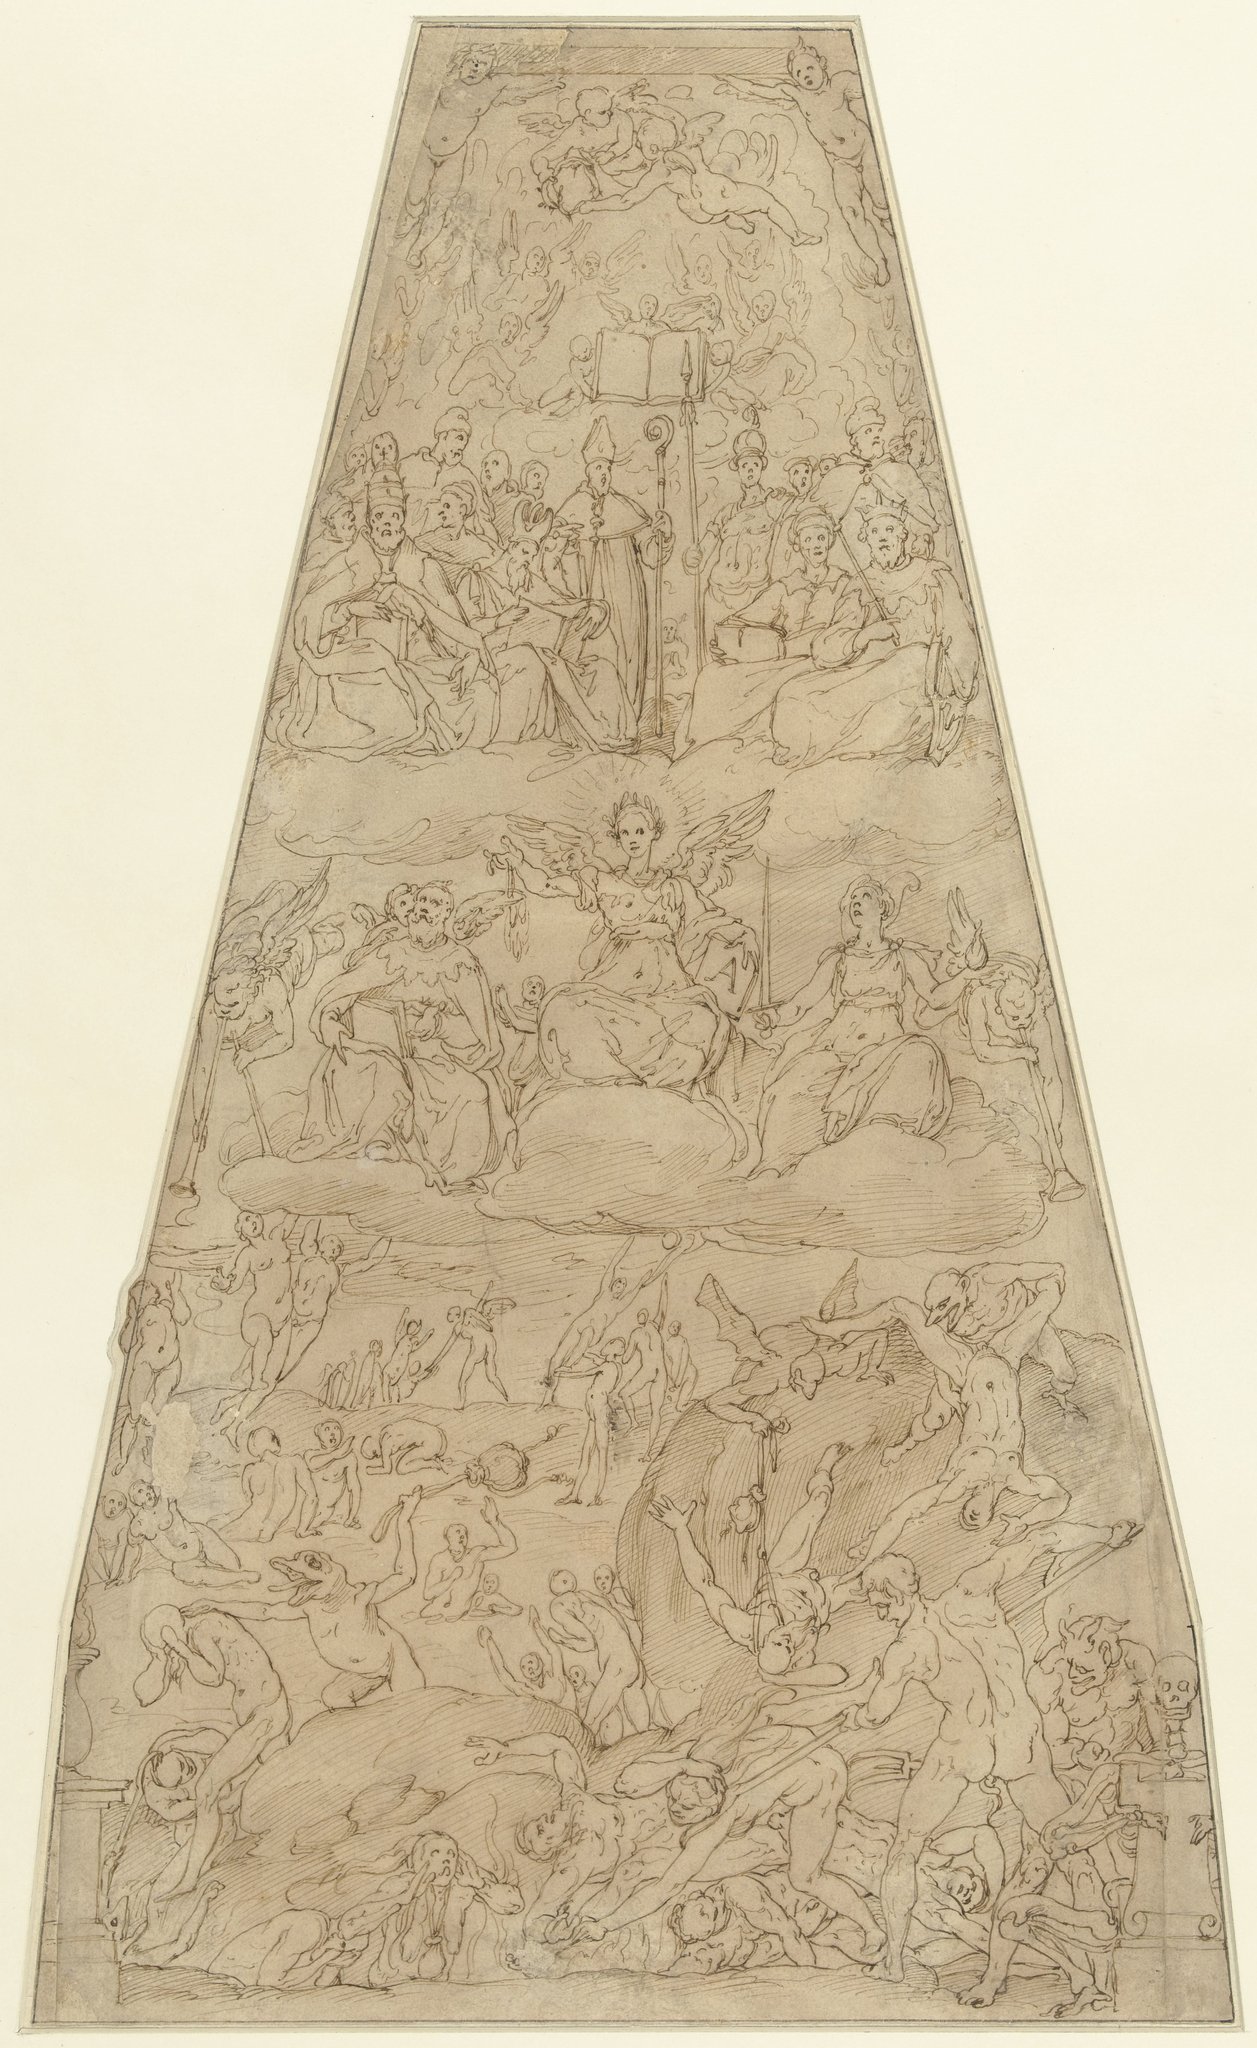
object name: drawing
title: Het Laatste Oordeel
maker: federico zuccaro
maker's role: draughtsman, print maker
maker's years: 1540-1609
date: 1552-1609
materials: ink, paper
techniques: pen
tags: last judgement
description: Naar een voorstudie voor de schildering in de koepel van de Dom te Florence.